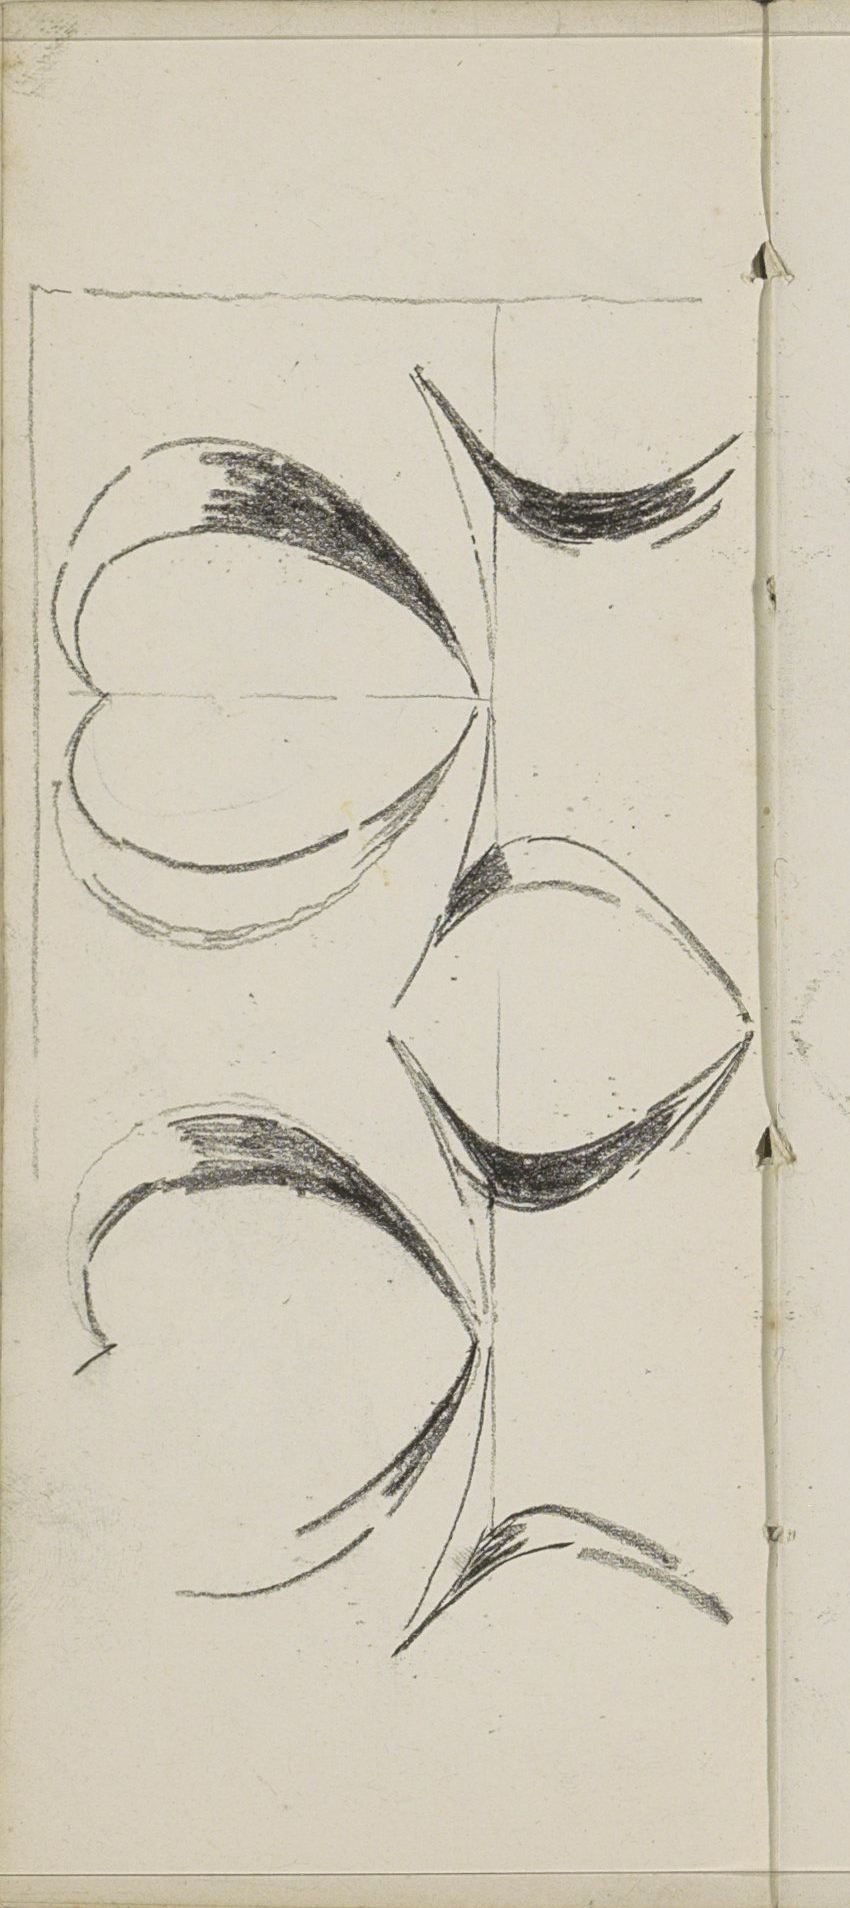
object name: sketchbook leaf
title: Hartvormige ornamenten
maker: gerrit willem dijsselhof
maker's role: designer, draughtsman, print maker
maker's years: 1866-1924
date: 1876-1924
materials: chalk, paper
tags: fantasy ornament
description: Blad 27 verso uit een schetsboek met 40 bladen.